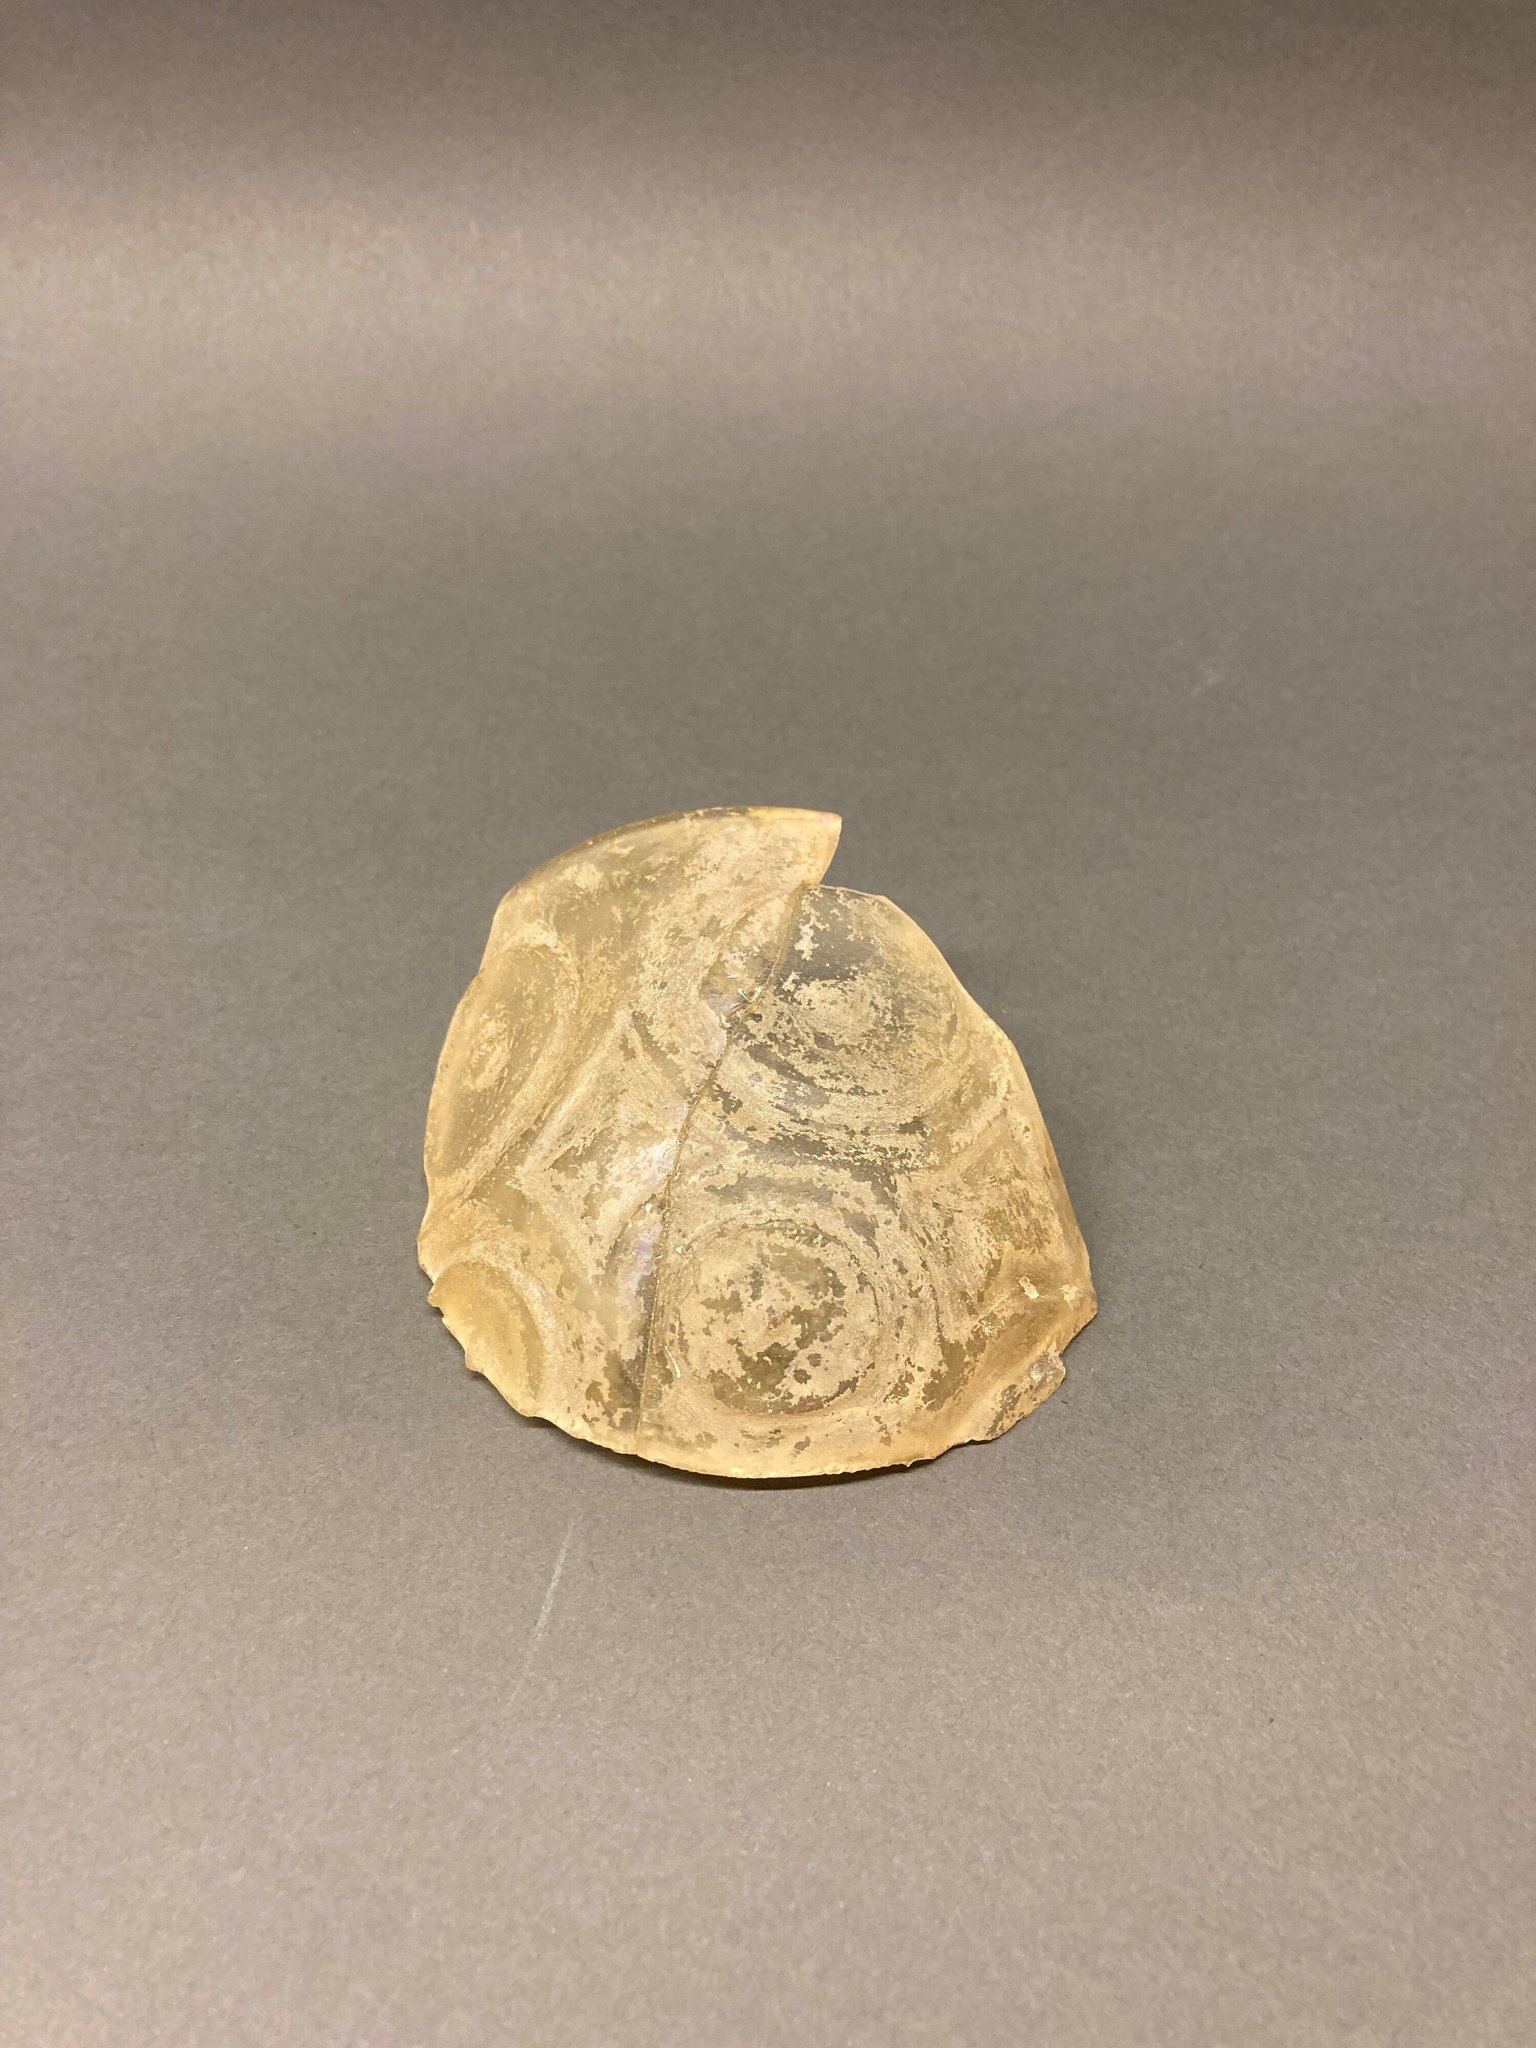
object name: fragment of a beaker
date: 801-1000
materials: glass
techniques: cutting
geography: iran